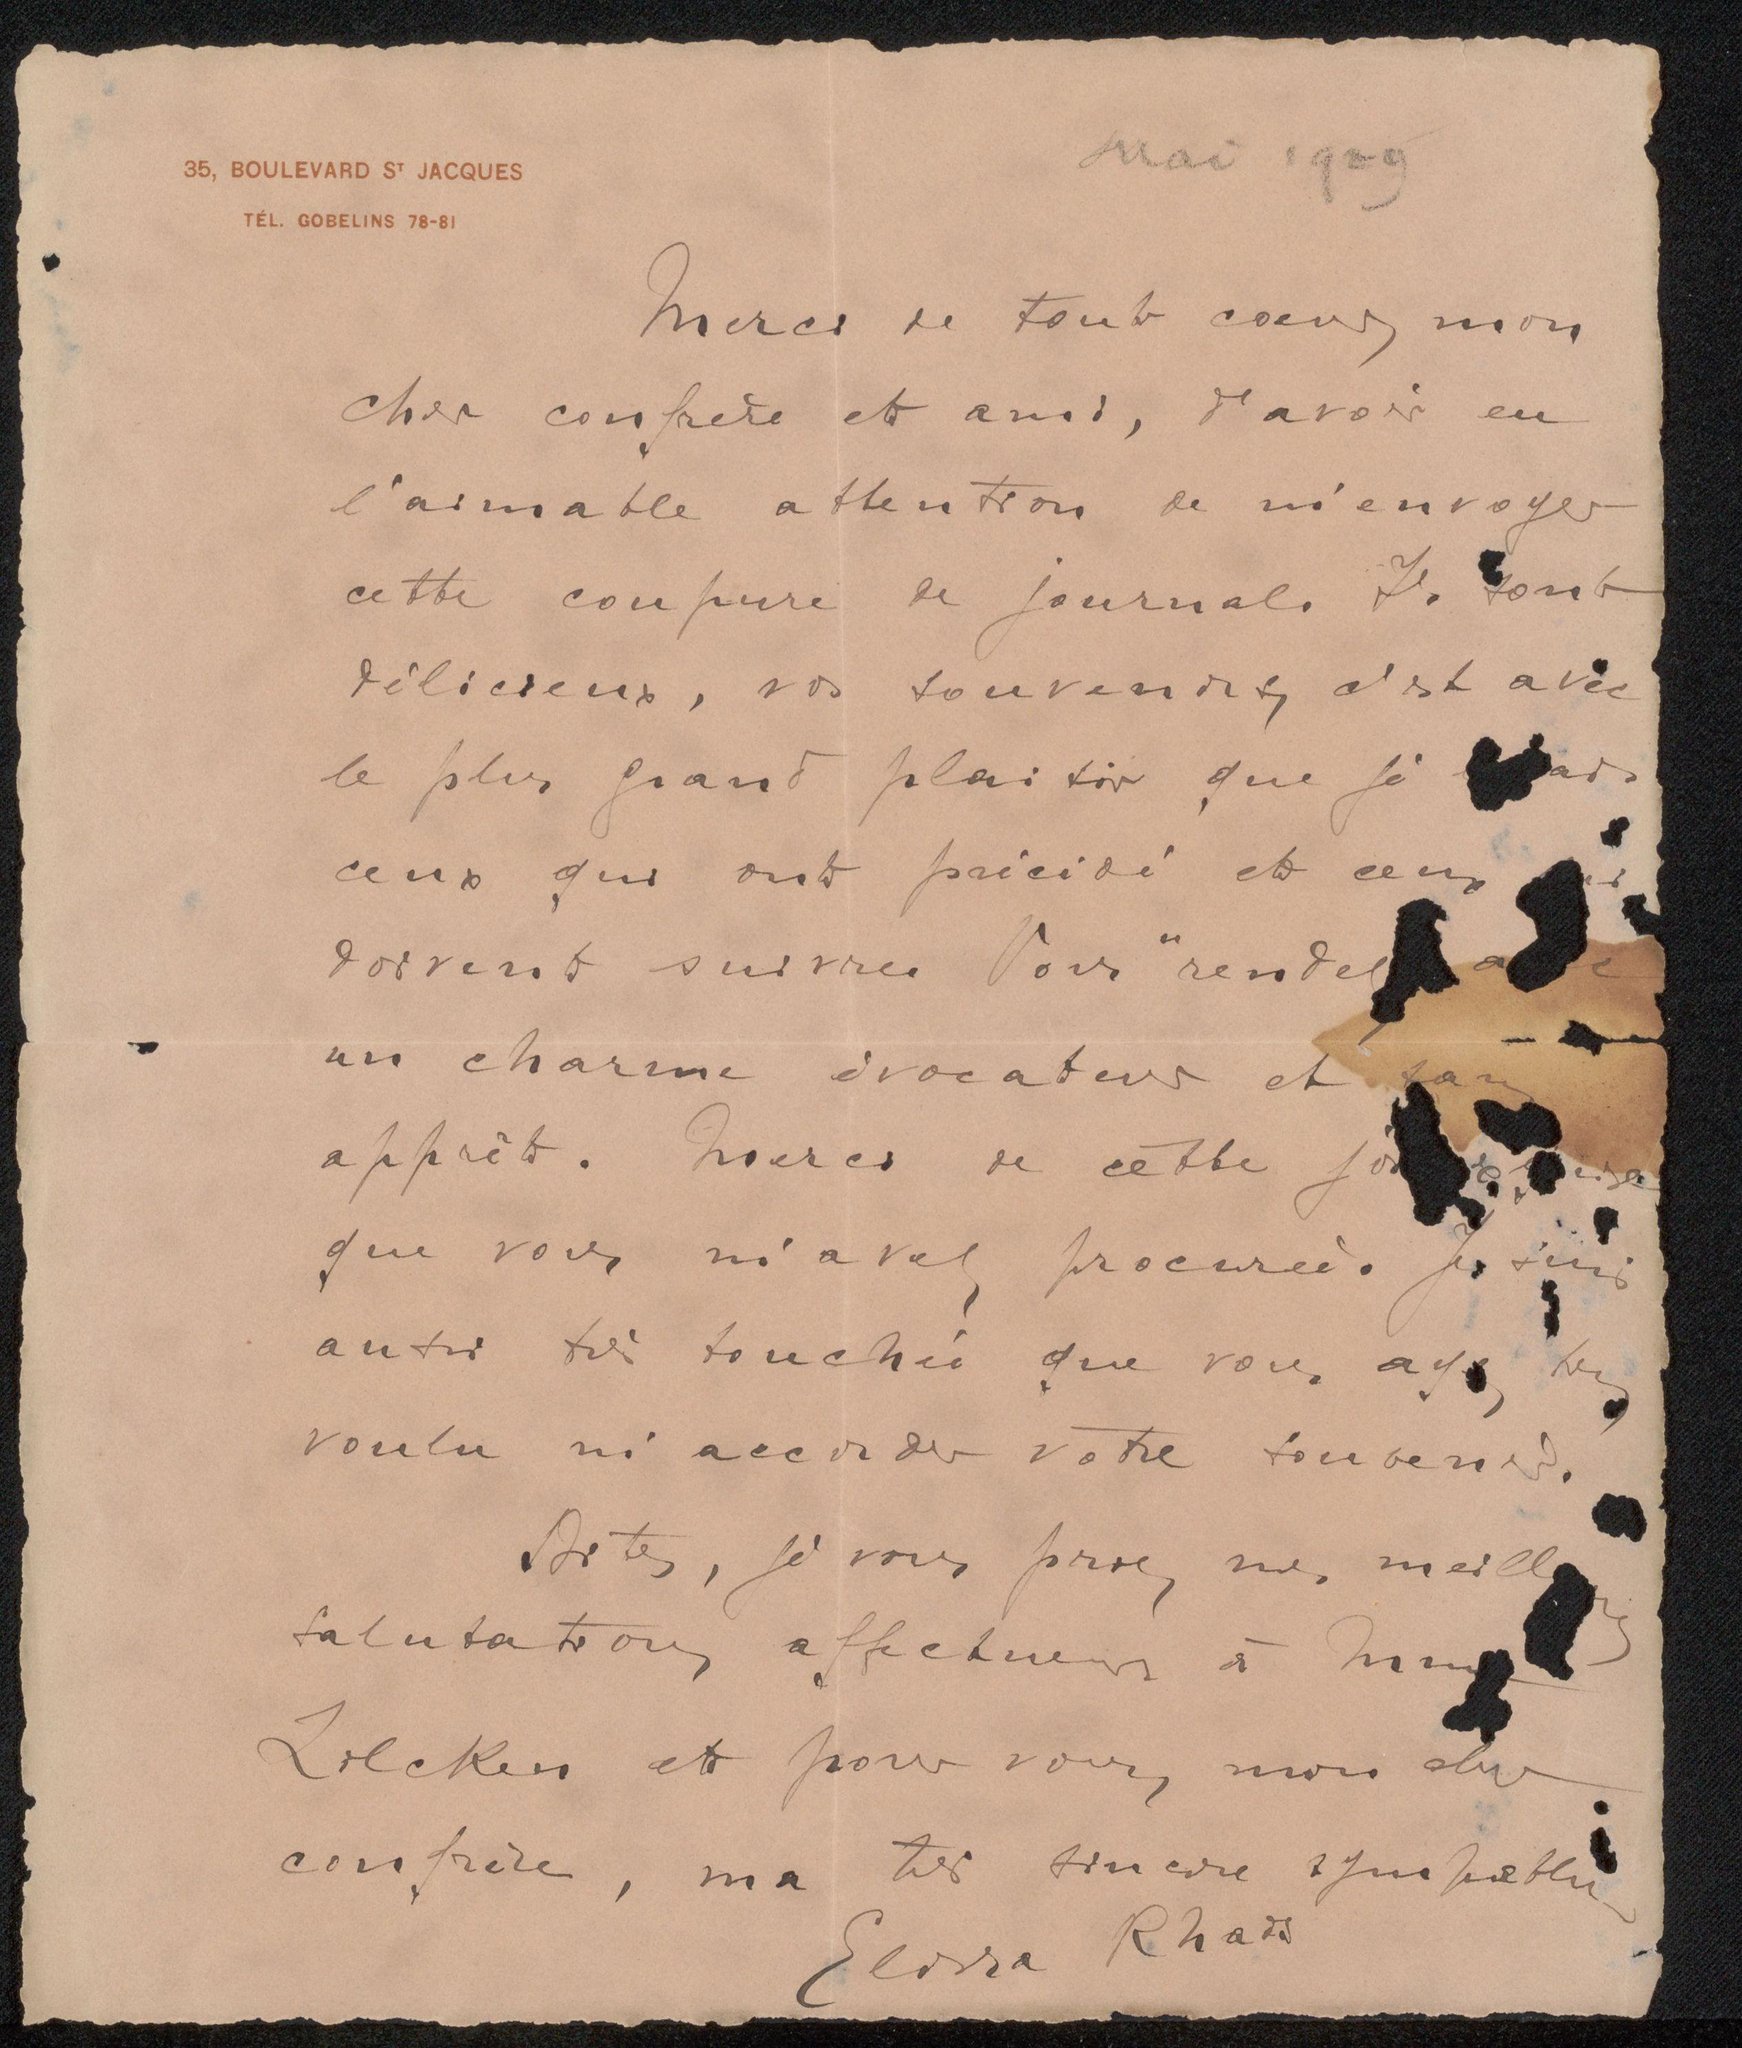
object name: letter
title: Brief aan Philip Zilcken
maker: elissa rhaïs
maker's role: romanschrijver, schrijver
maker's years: 1876-1940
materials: ink, paper, pencil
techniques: pen, printing, writing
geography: paris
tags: the hague, painter, philip zilcken, printed matter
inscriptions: collector's mark: ‘RPK’